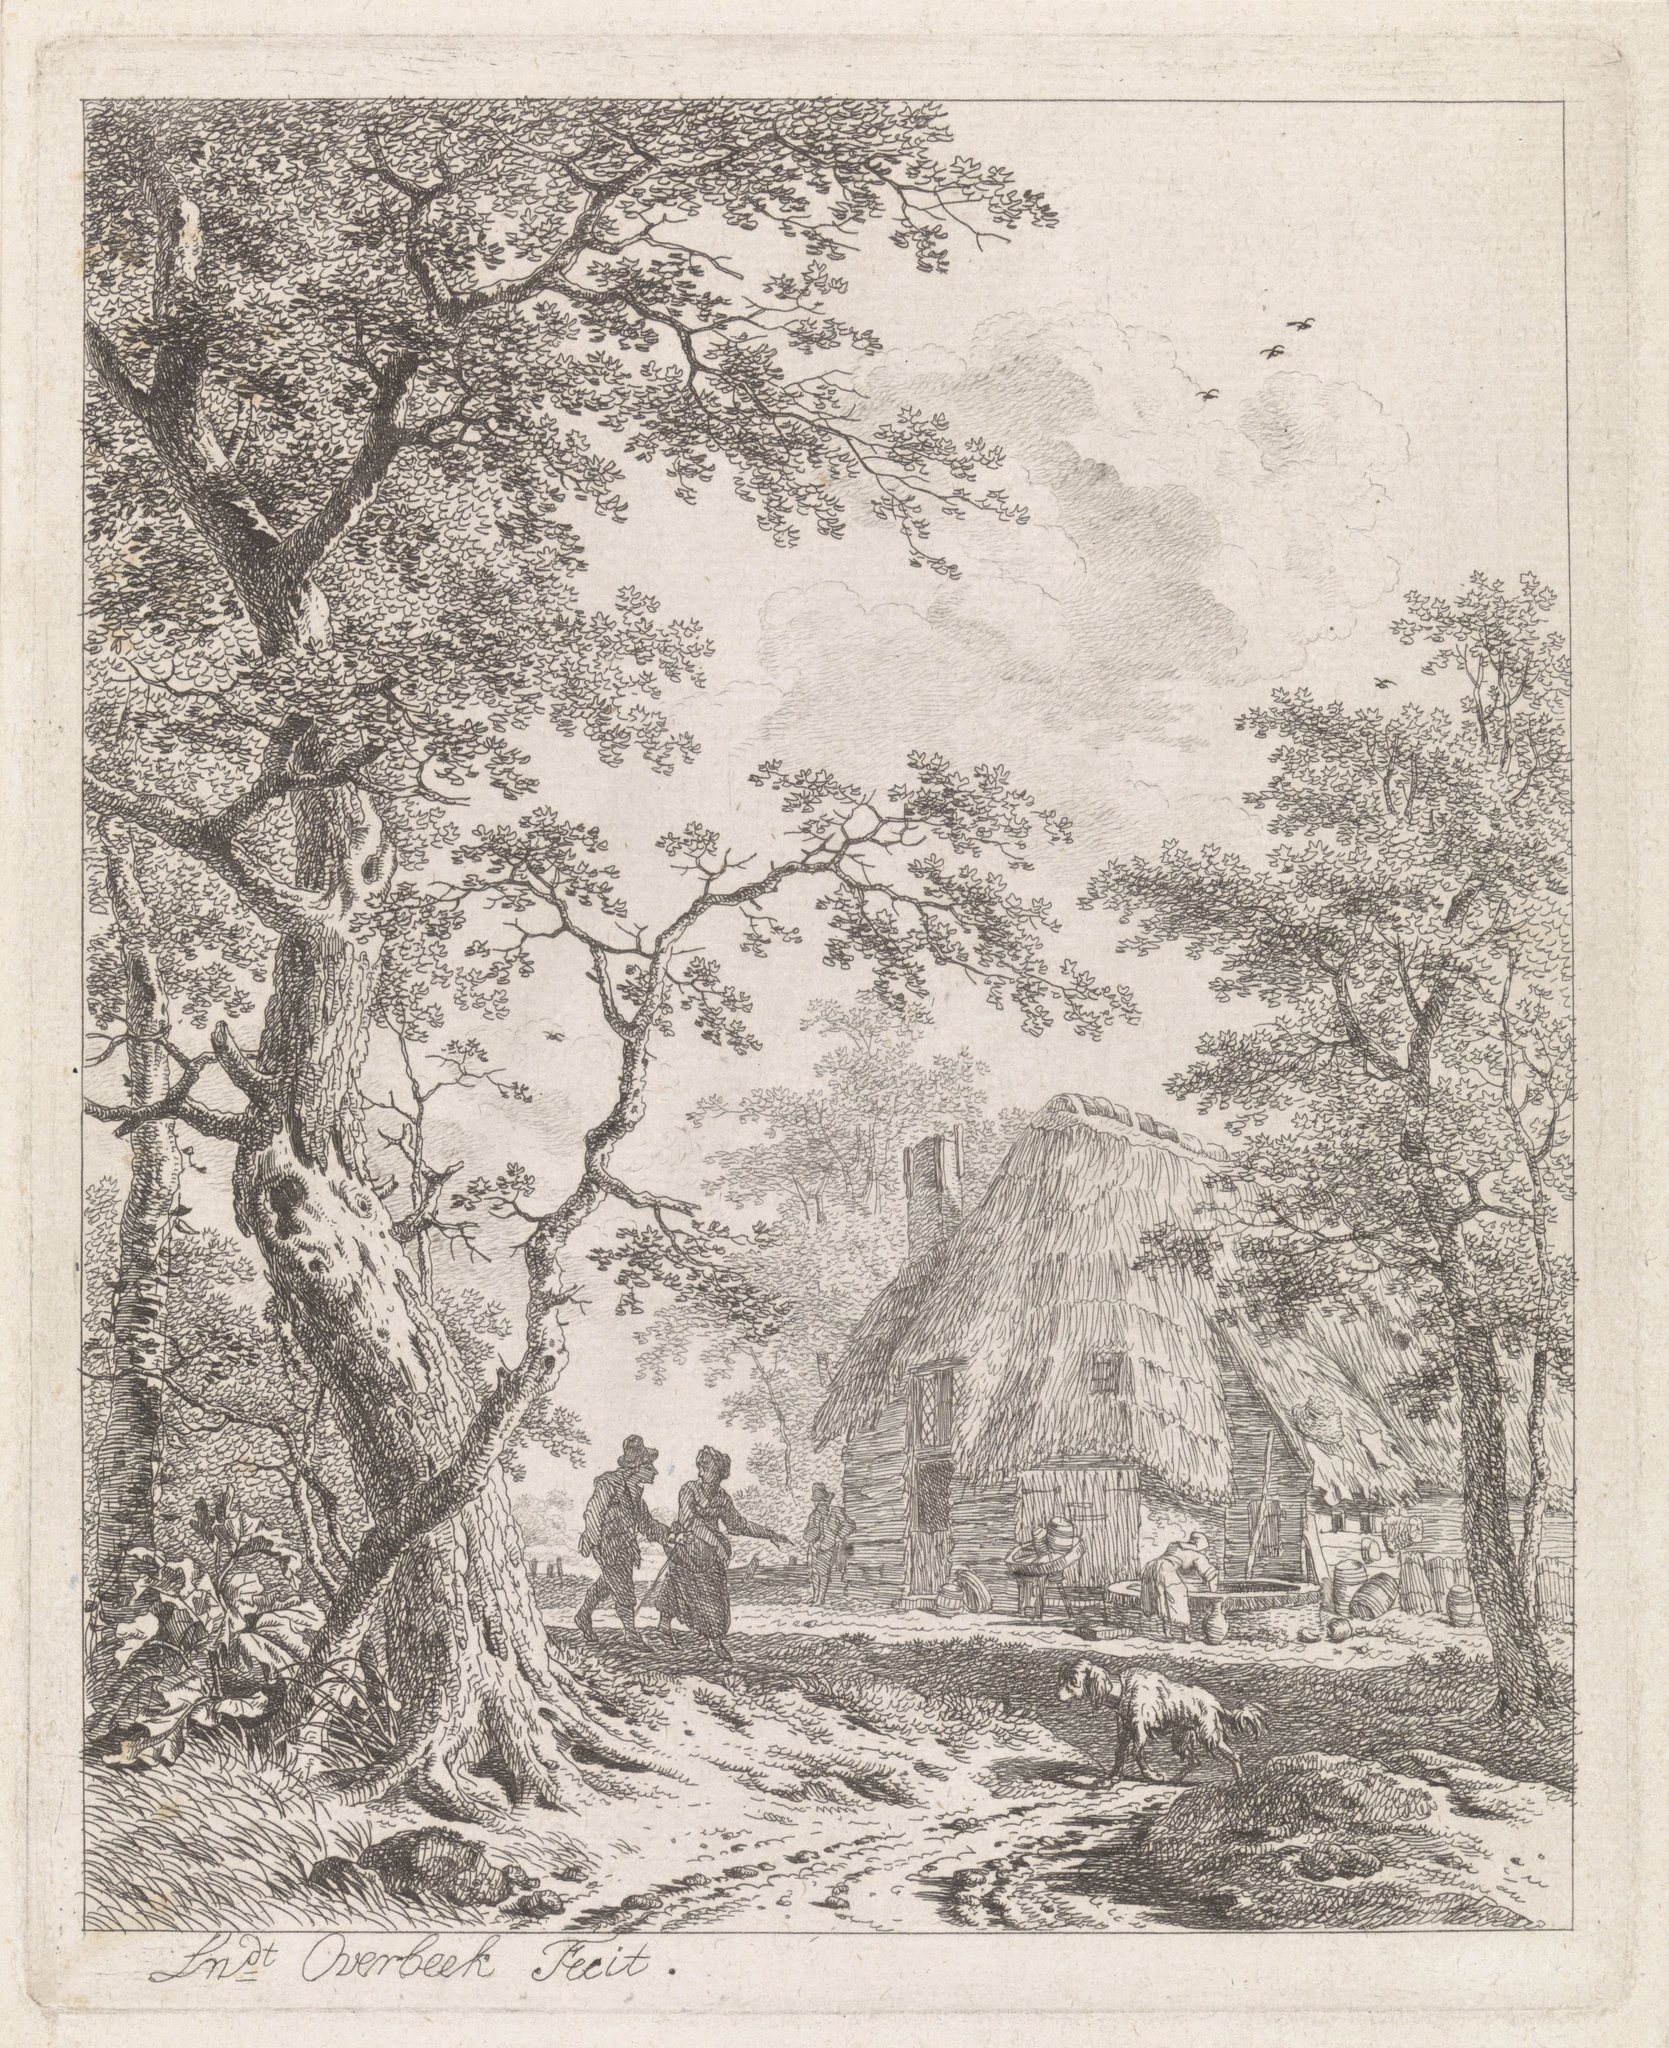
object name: print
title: Twee wandelaars bij een boerderij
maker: leendert overbeek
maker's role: draughtsman, painter, print maker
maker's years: 1752-1815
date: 1791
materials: paper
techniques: etching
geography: haarlem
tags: landscapes in the temperate zone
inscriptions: collector's mark: Lugt 2228